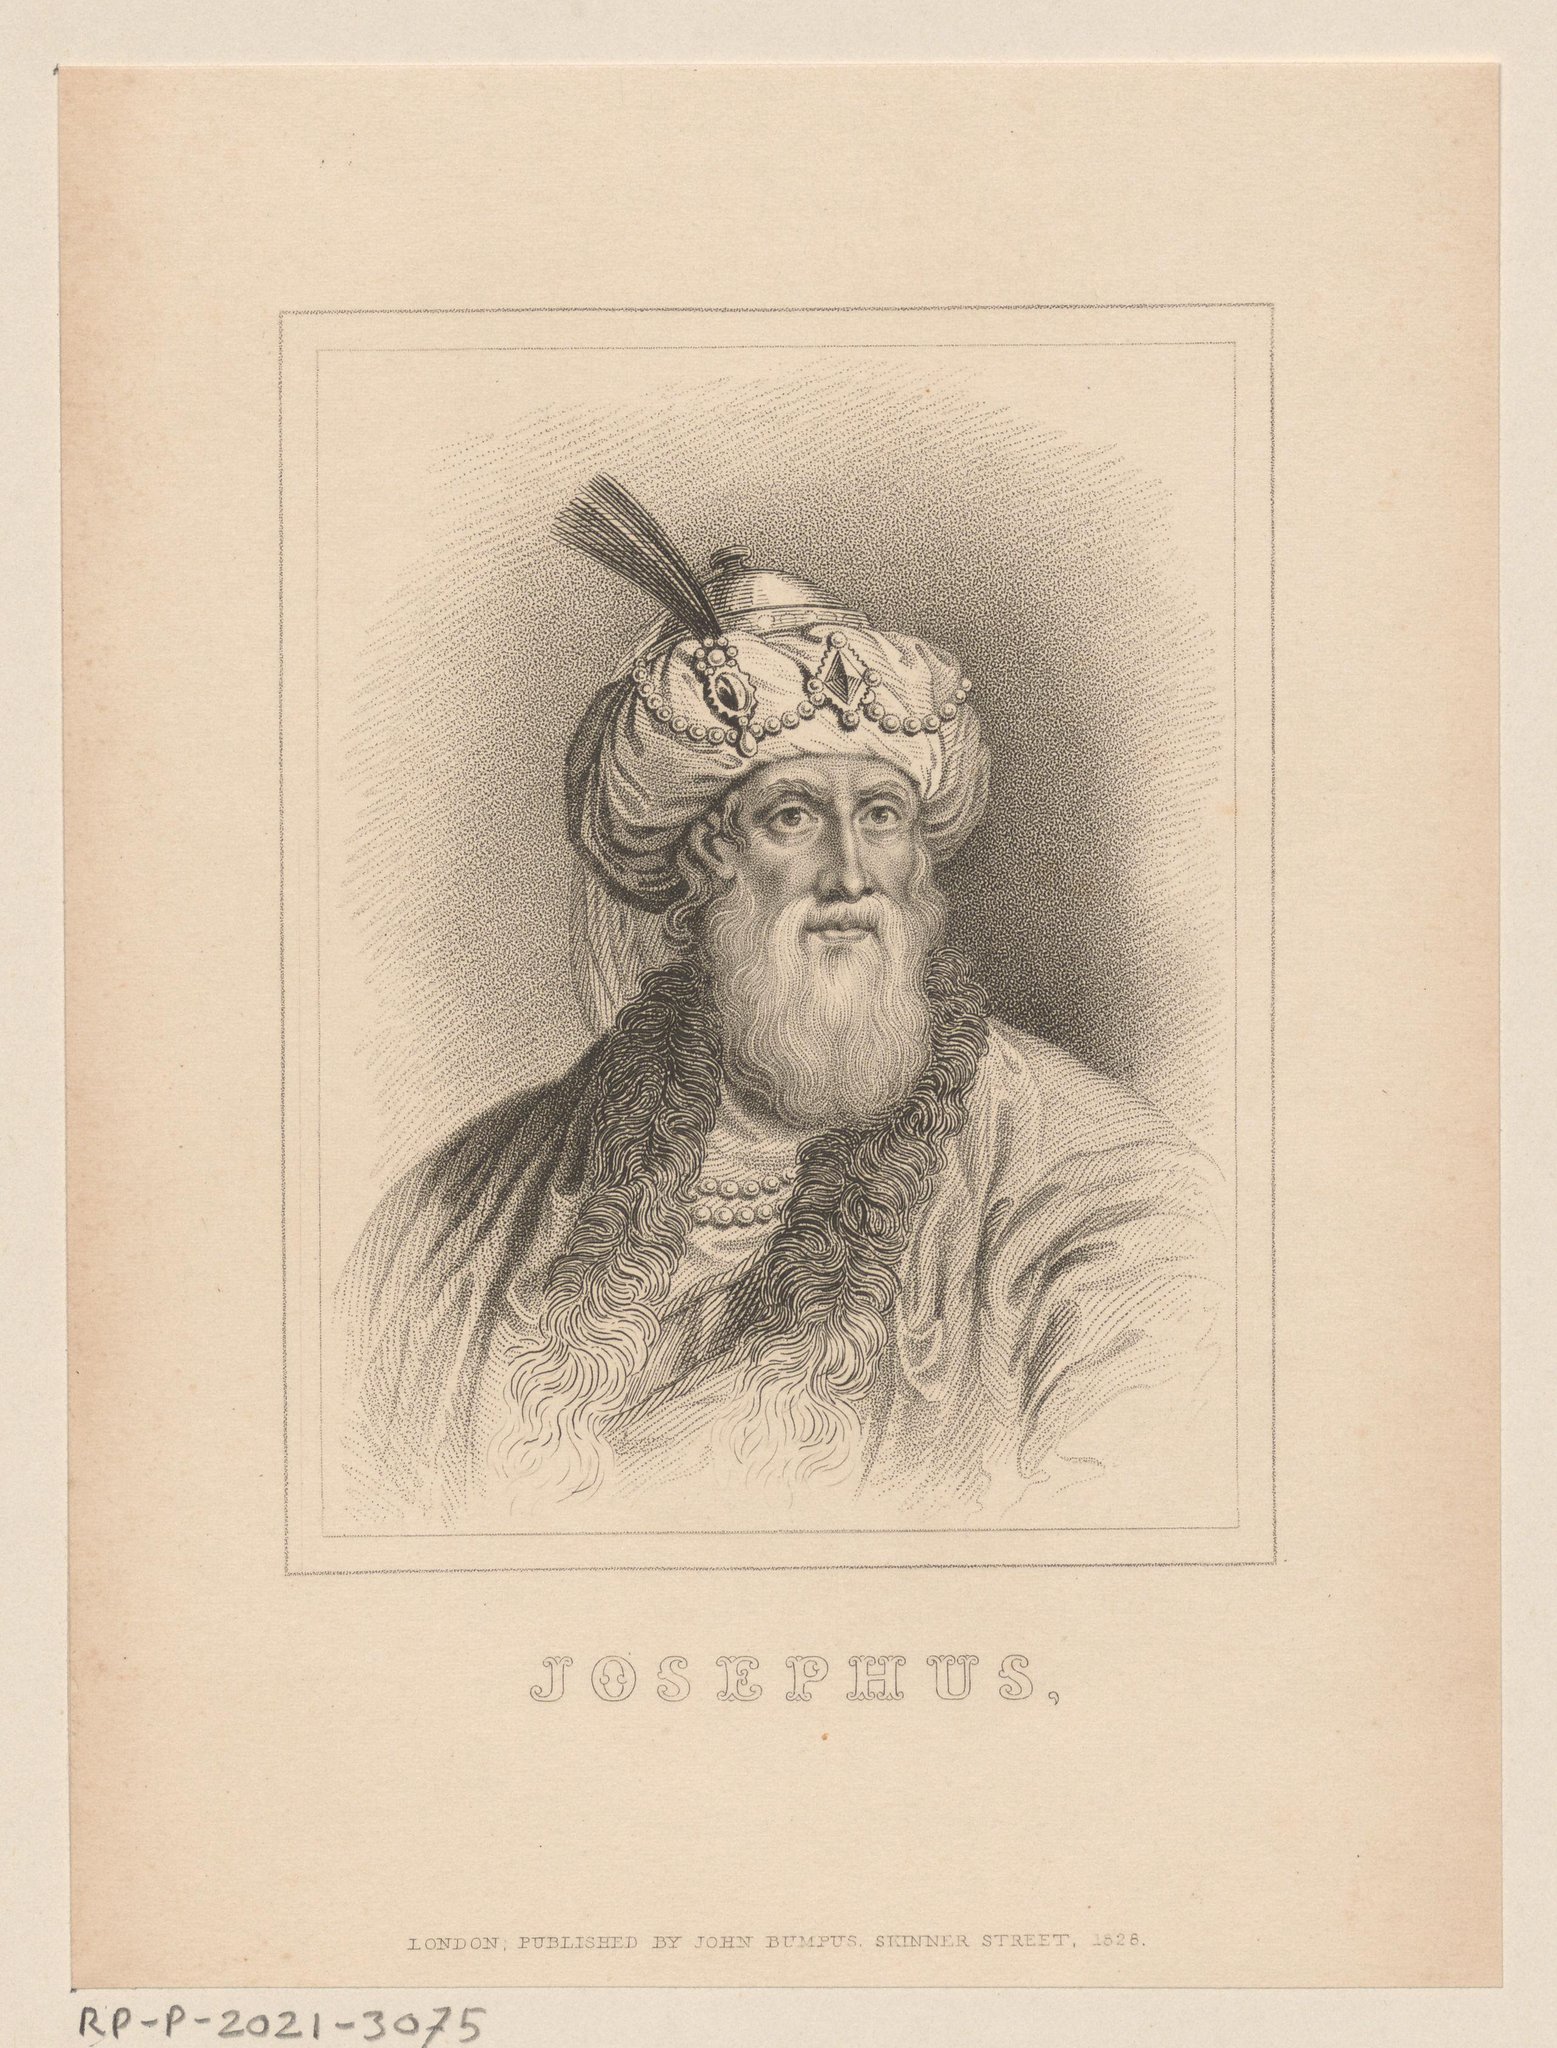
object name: print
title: Portret van Flavius Josephus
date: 1828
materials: paper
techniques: engraving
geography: london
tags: rome, historical persons, portrait of a writer